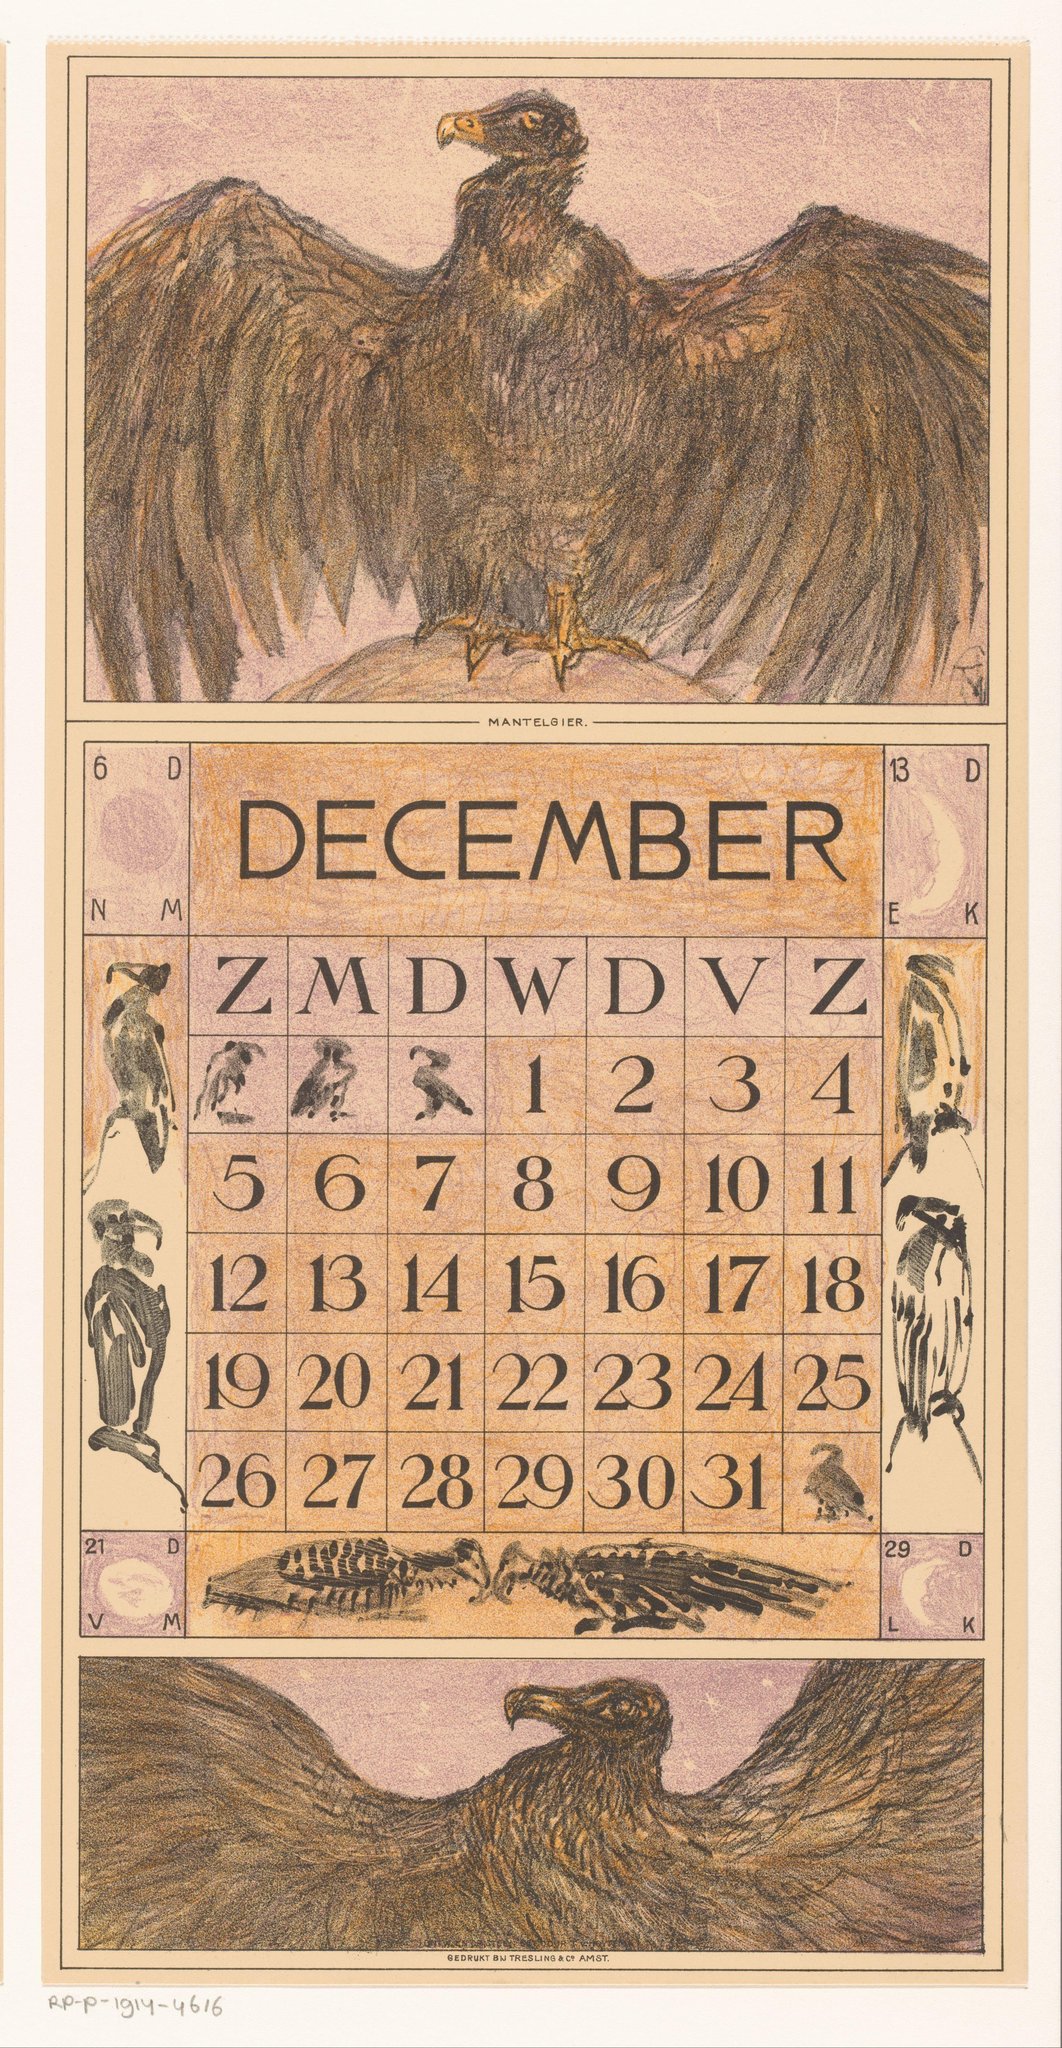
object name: print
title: Kalenderblad december met gier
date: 1914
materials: paper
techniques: lithograph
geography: amsterdam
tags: lunar year, predatory birds: vulture, december ~ other concepts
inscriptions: collector's mark: Lugt 2233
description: De gier heeft zijn vleugels uitgeslagen. In de hoeken de standen van de maan op vier dagen. Bovenaan het blad een scheurlijn.